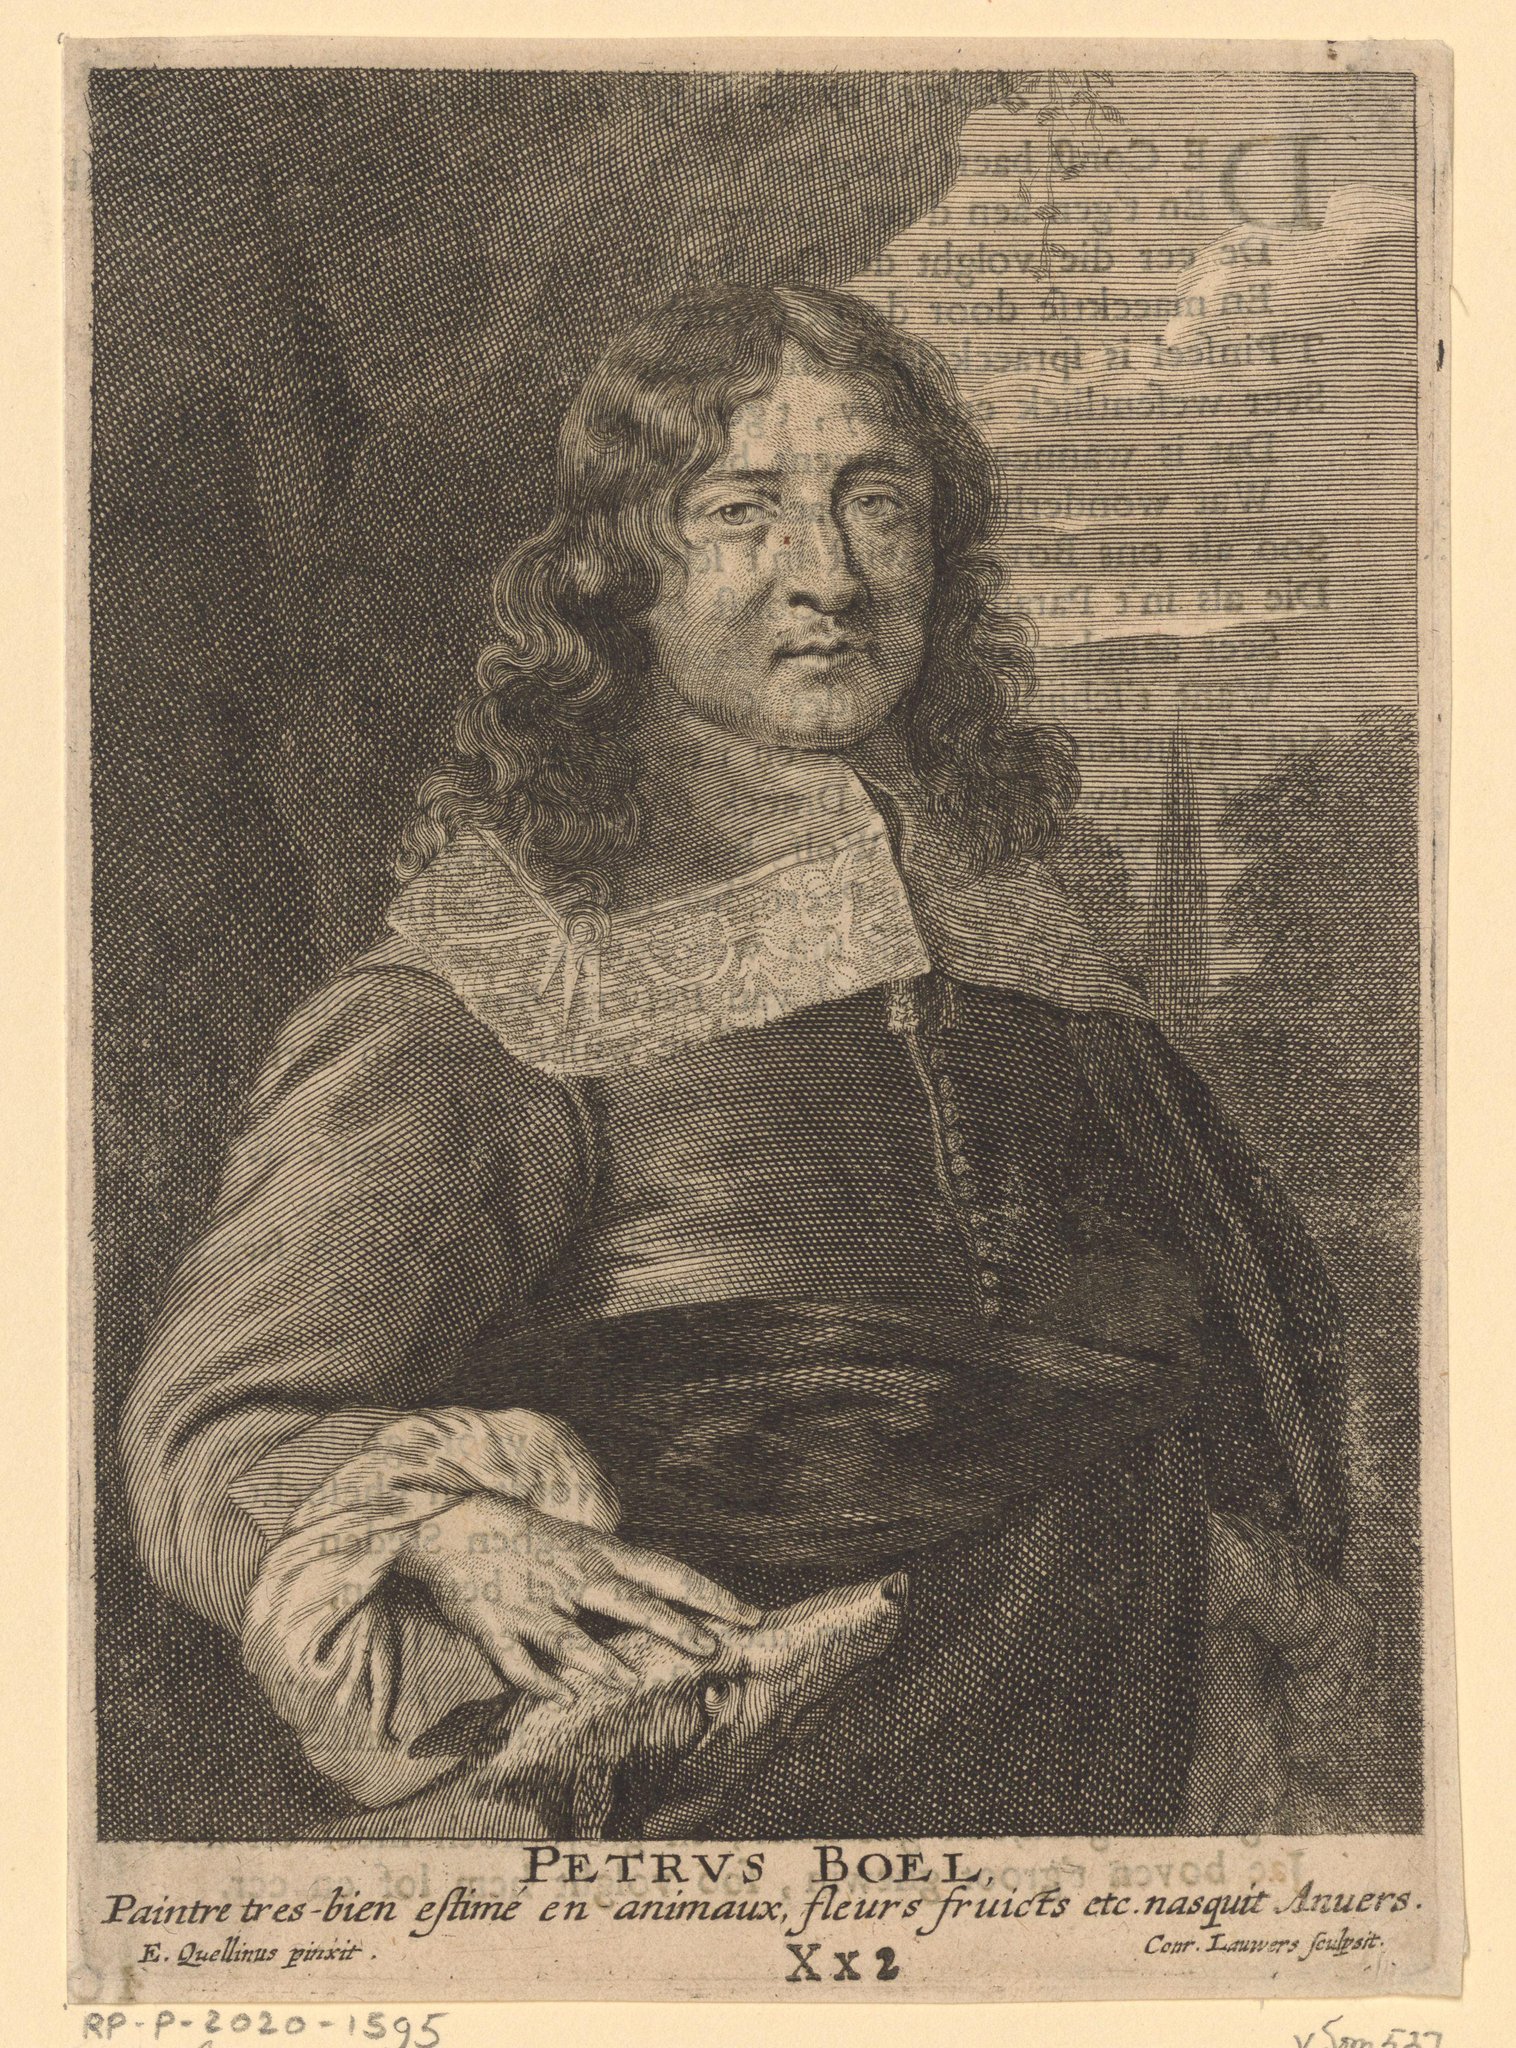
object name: book illustration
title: Portret van Peeter Boel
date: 1649-1662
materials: paper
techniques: engraving, letterpress printing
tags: antwerp, paris, painter, print maker, peeter boel, historical persons, portrait, self-portrait of painter, dog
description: Prent gebruikt in: Bie, Cornelis De. Het gulden Cabinet vande edel vry schilder const, inhoudende den lof vande vermarste schilders, architecte, beldthowers ende plaetsnyders van dese eeuw. Antwerpen: Joannes Meyssens, 1662 [1661 foutief op titelpagina]. En mogelijk ook al in: Meyssens, Joannes. Image de divers hommes desprit sublime qui par leur art et science deburovent vivre eternellement et des quels la louange et renommée faict estonner le monde. 2 dln. Antwerpen: Joannes Meyssens, 1649.